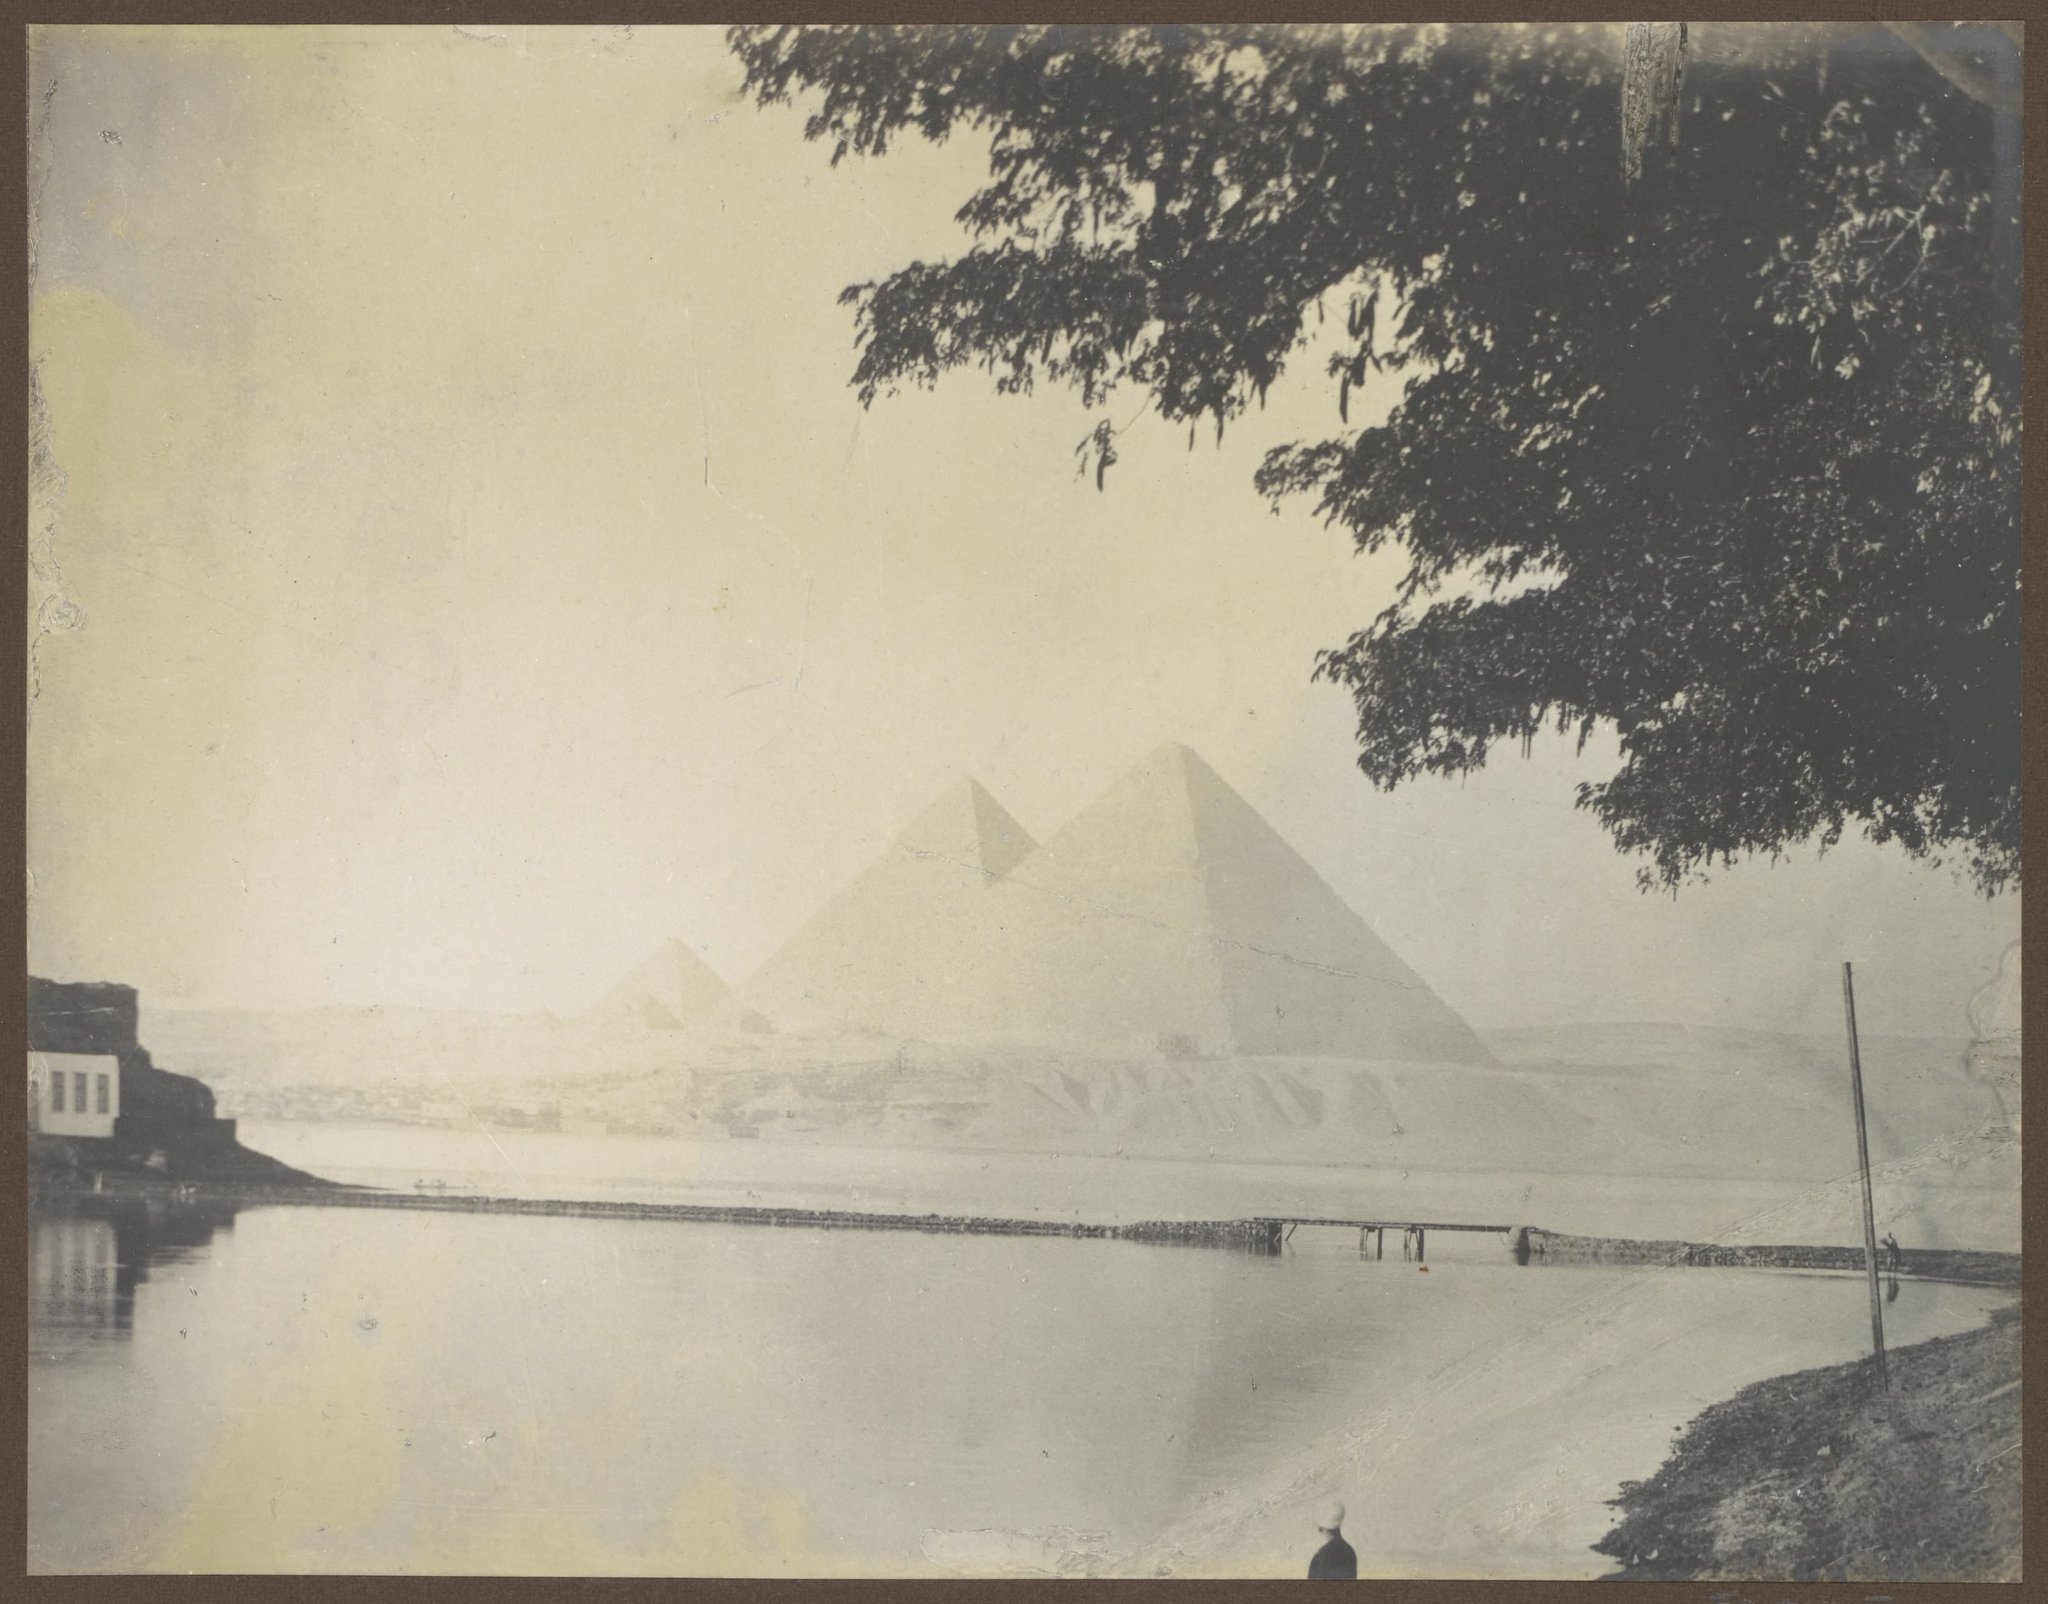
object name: photograph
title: Gezicht op de piramides van Gizeh vanaf het water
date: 1880-1900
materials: paper, photographic support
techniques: gelatin silver print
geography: gizeh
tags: pyramid (historical grave form)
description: Onderdeel van Reisalbum met foto's van Duitsland, Zwitserland, het Suezkanaal en Nederlands-Indië.